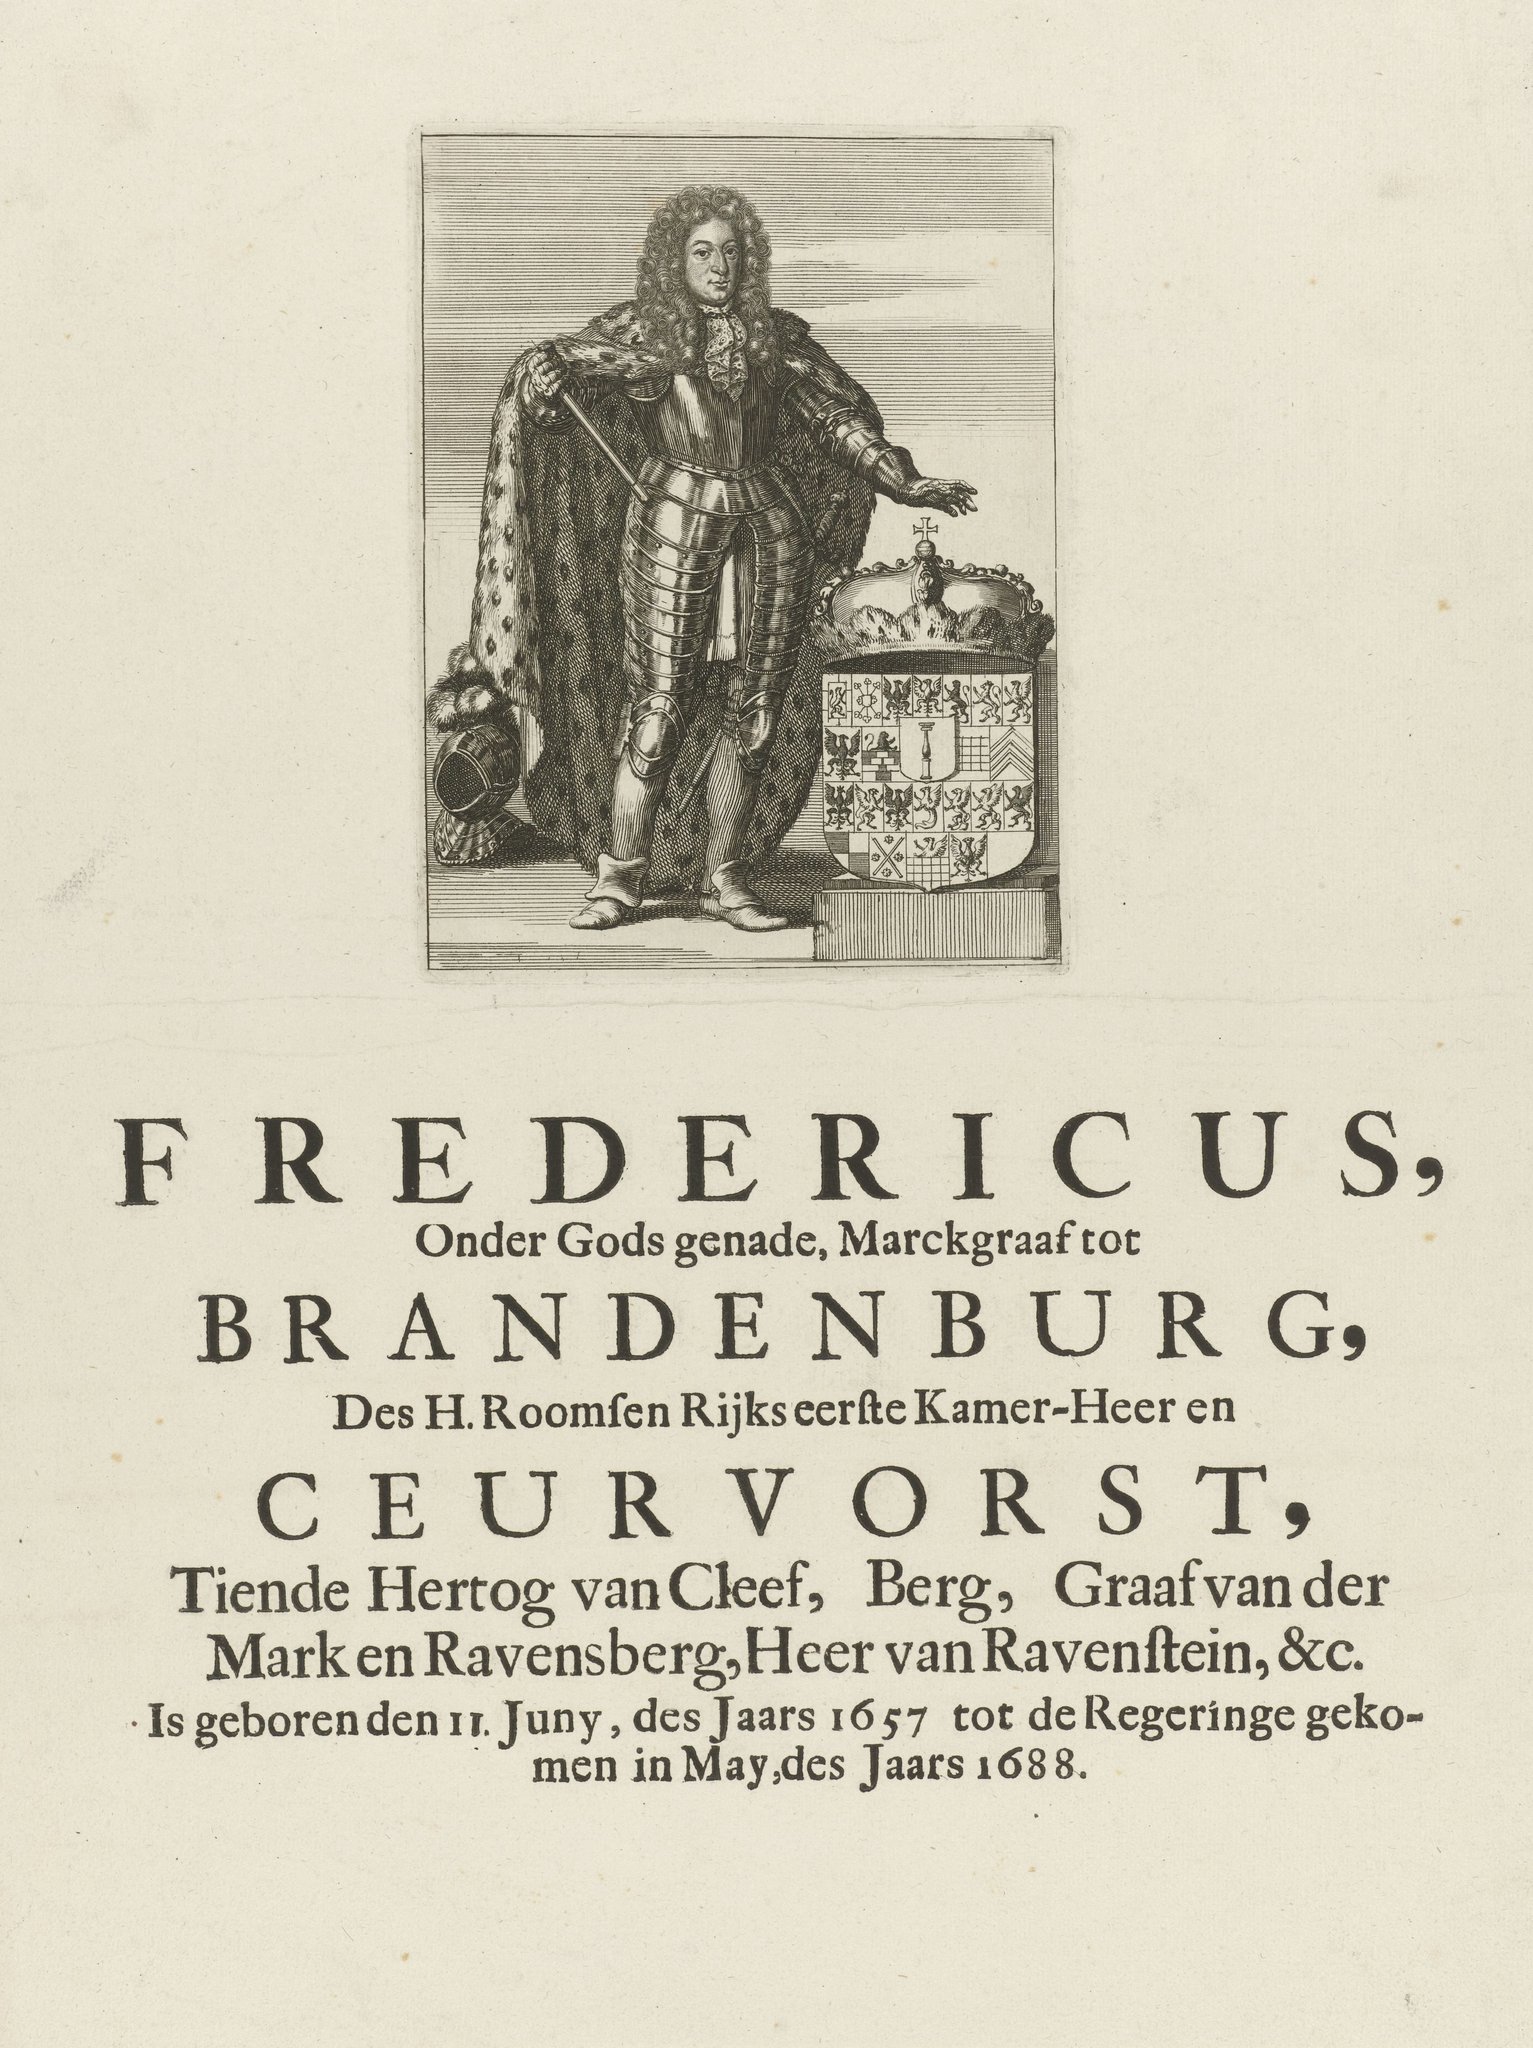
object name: print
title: Portret van Frederik I, koning van Pruisen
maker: jan luyken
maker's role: draughtsman, print maker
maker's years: 1649-1712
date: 1688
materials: paper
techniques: etching, letterpress printing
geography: amsterdam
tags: berlin, frederik i koning van pruisen, coat of arms (as symbol of the state, etc.) (+ city; municipal)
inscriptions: collector's mark: Lugt 2228